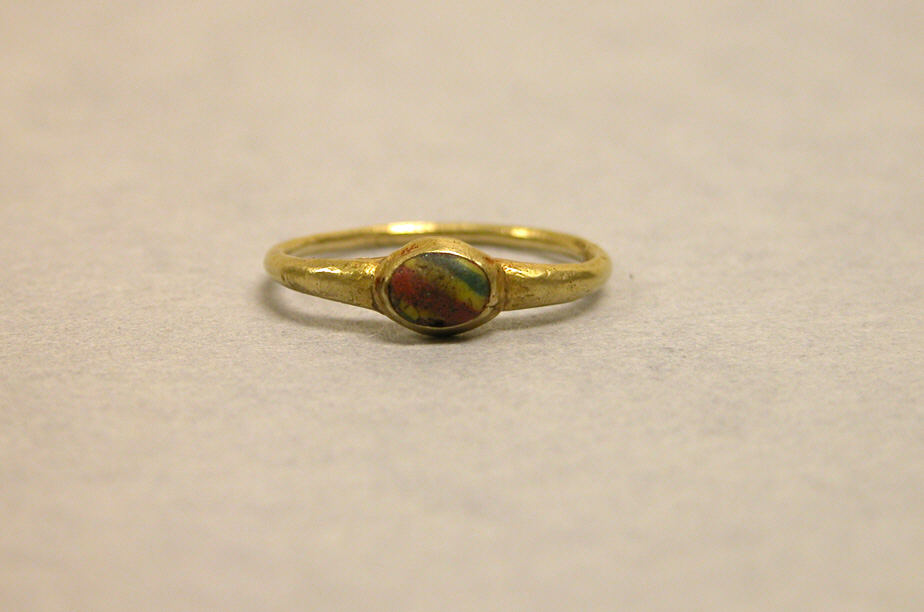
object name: ring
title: Ring with Stone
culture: indonesian, central java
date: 701-1200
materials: gold